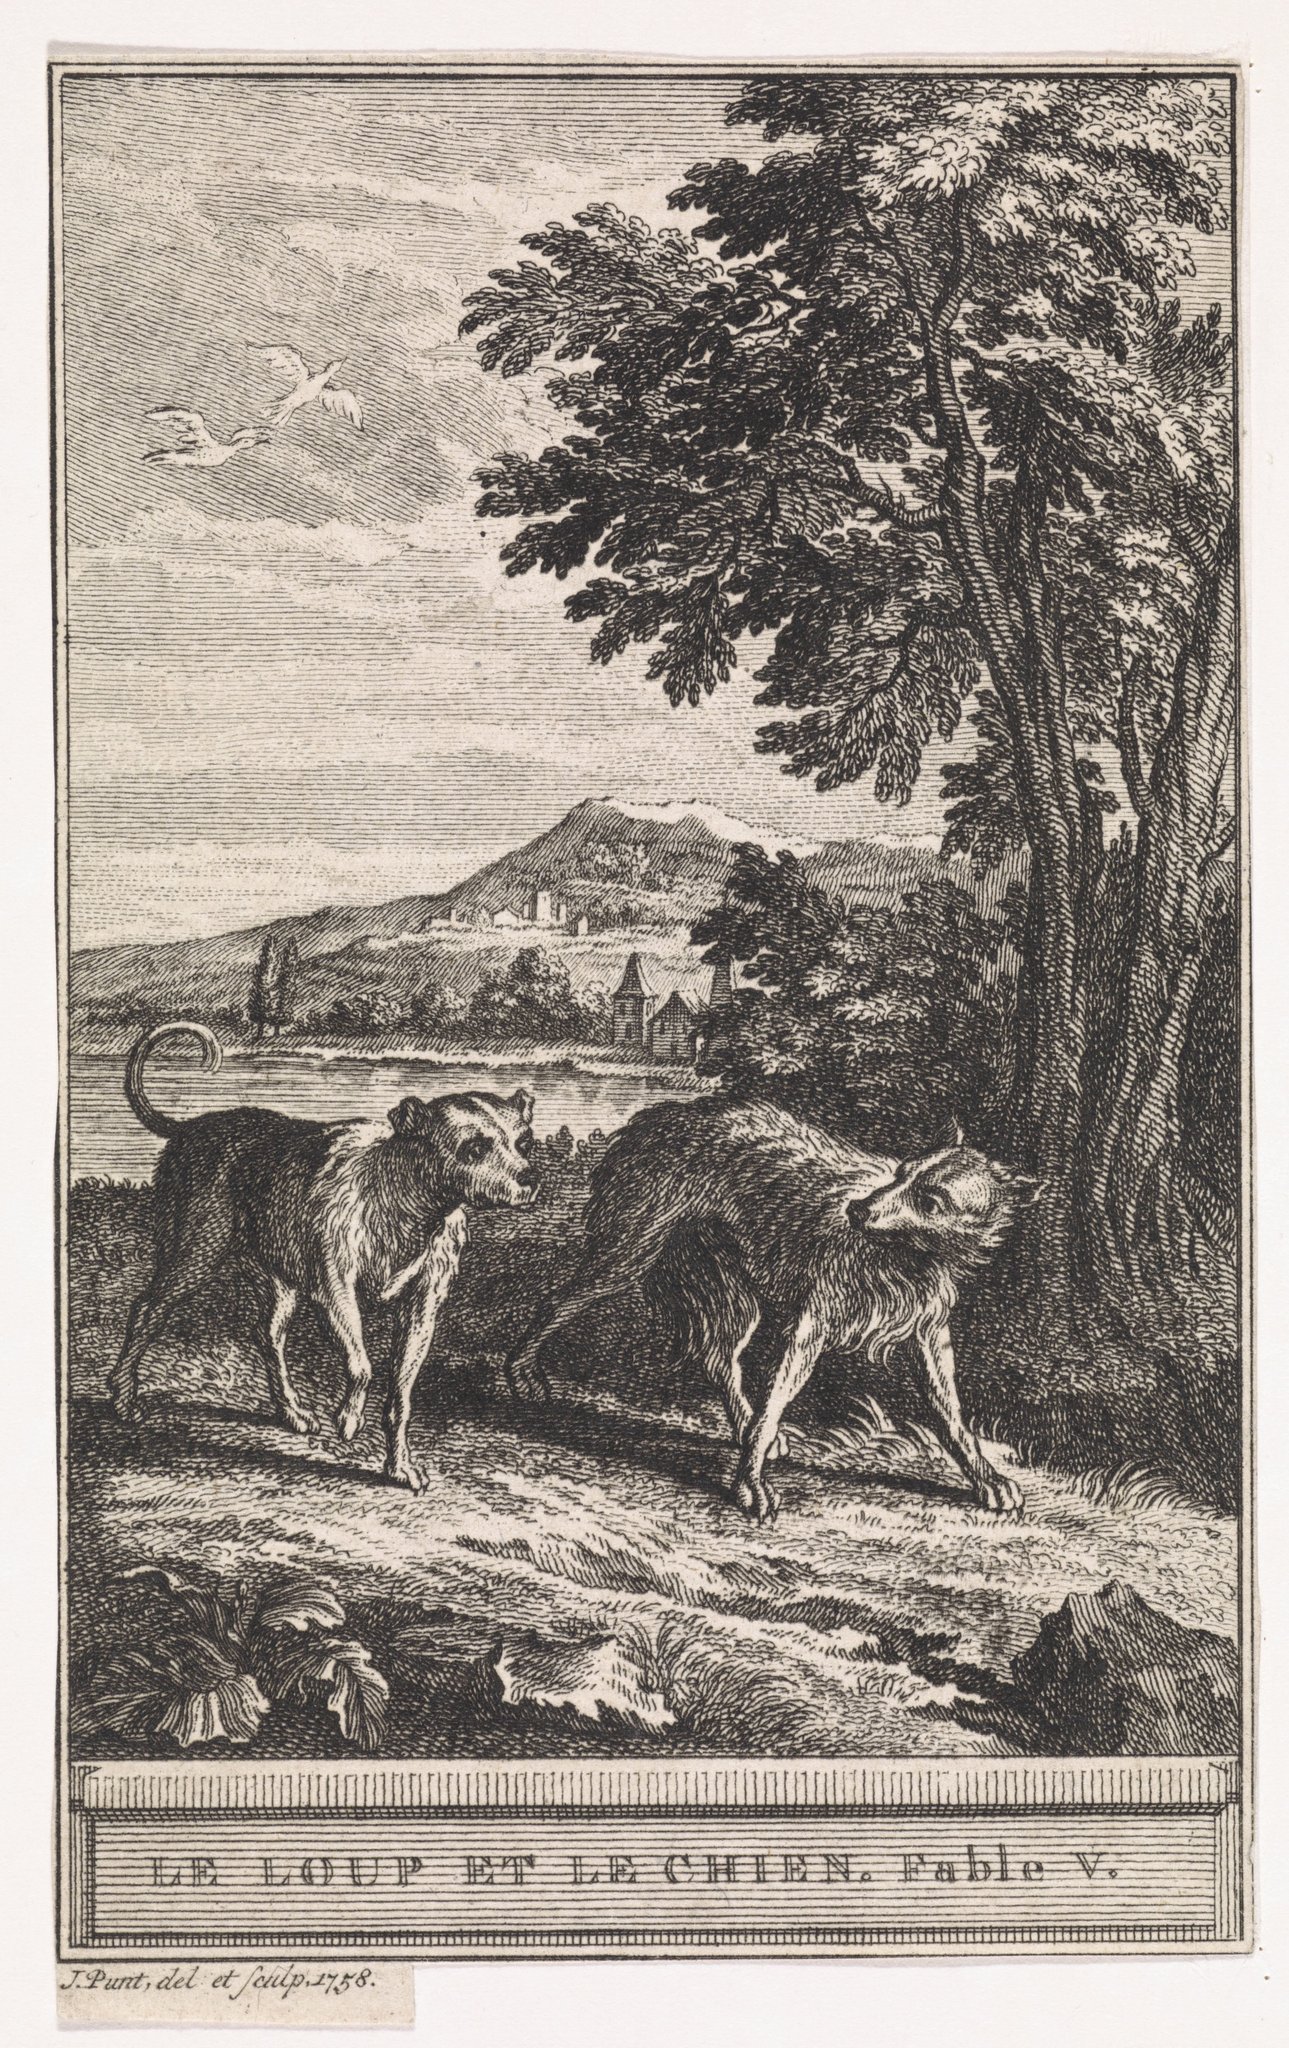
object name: book illustration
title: Le loup et le chien. Fable V.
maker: jan punt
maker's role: draughtsman, print maker, publisher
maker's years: 1711-1779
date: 1758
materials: paper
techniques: engraving, etching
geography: amsterdam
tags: specific works of literature, dog, beasts of prey, predatory animals: wolf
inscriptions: collector's mark: Lugt 2228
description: Prent gebruikt als illustratie in een of meerdere edities van: La Fontaine, Jean de. Fables choisies, deel I, p. 8. Leiden: Elie Luzac, 1764-1786. En in de editie uit Amsterdam: J. van Gulik, 1802.